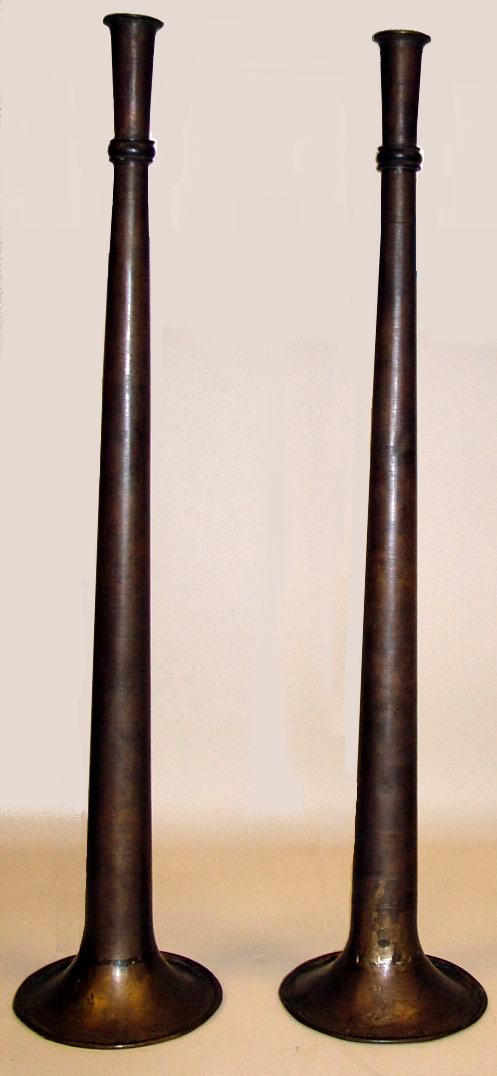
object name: nyastaranga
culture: indian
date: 1885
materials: metal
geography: india